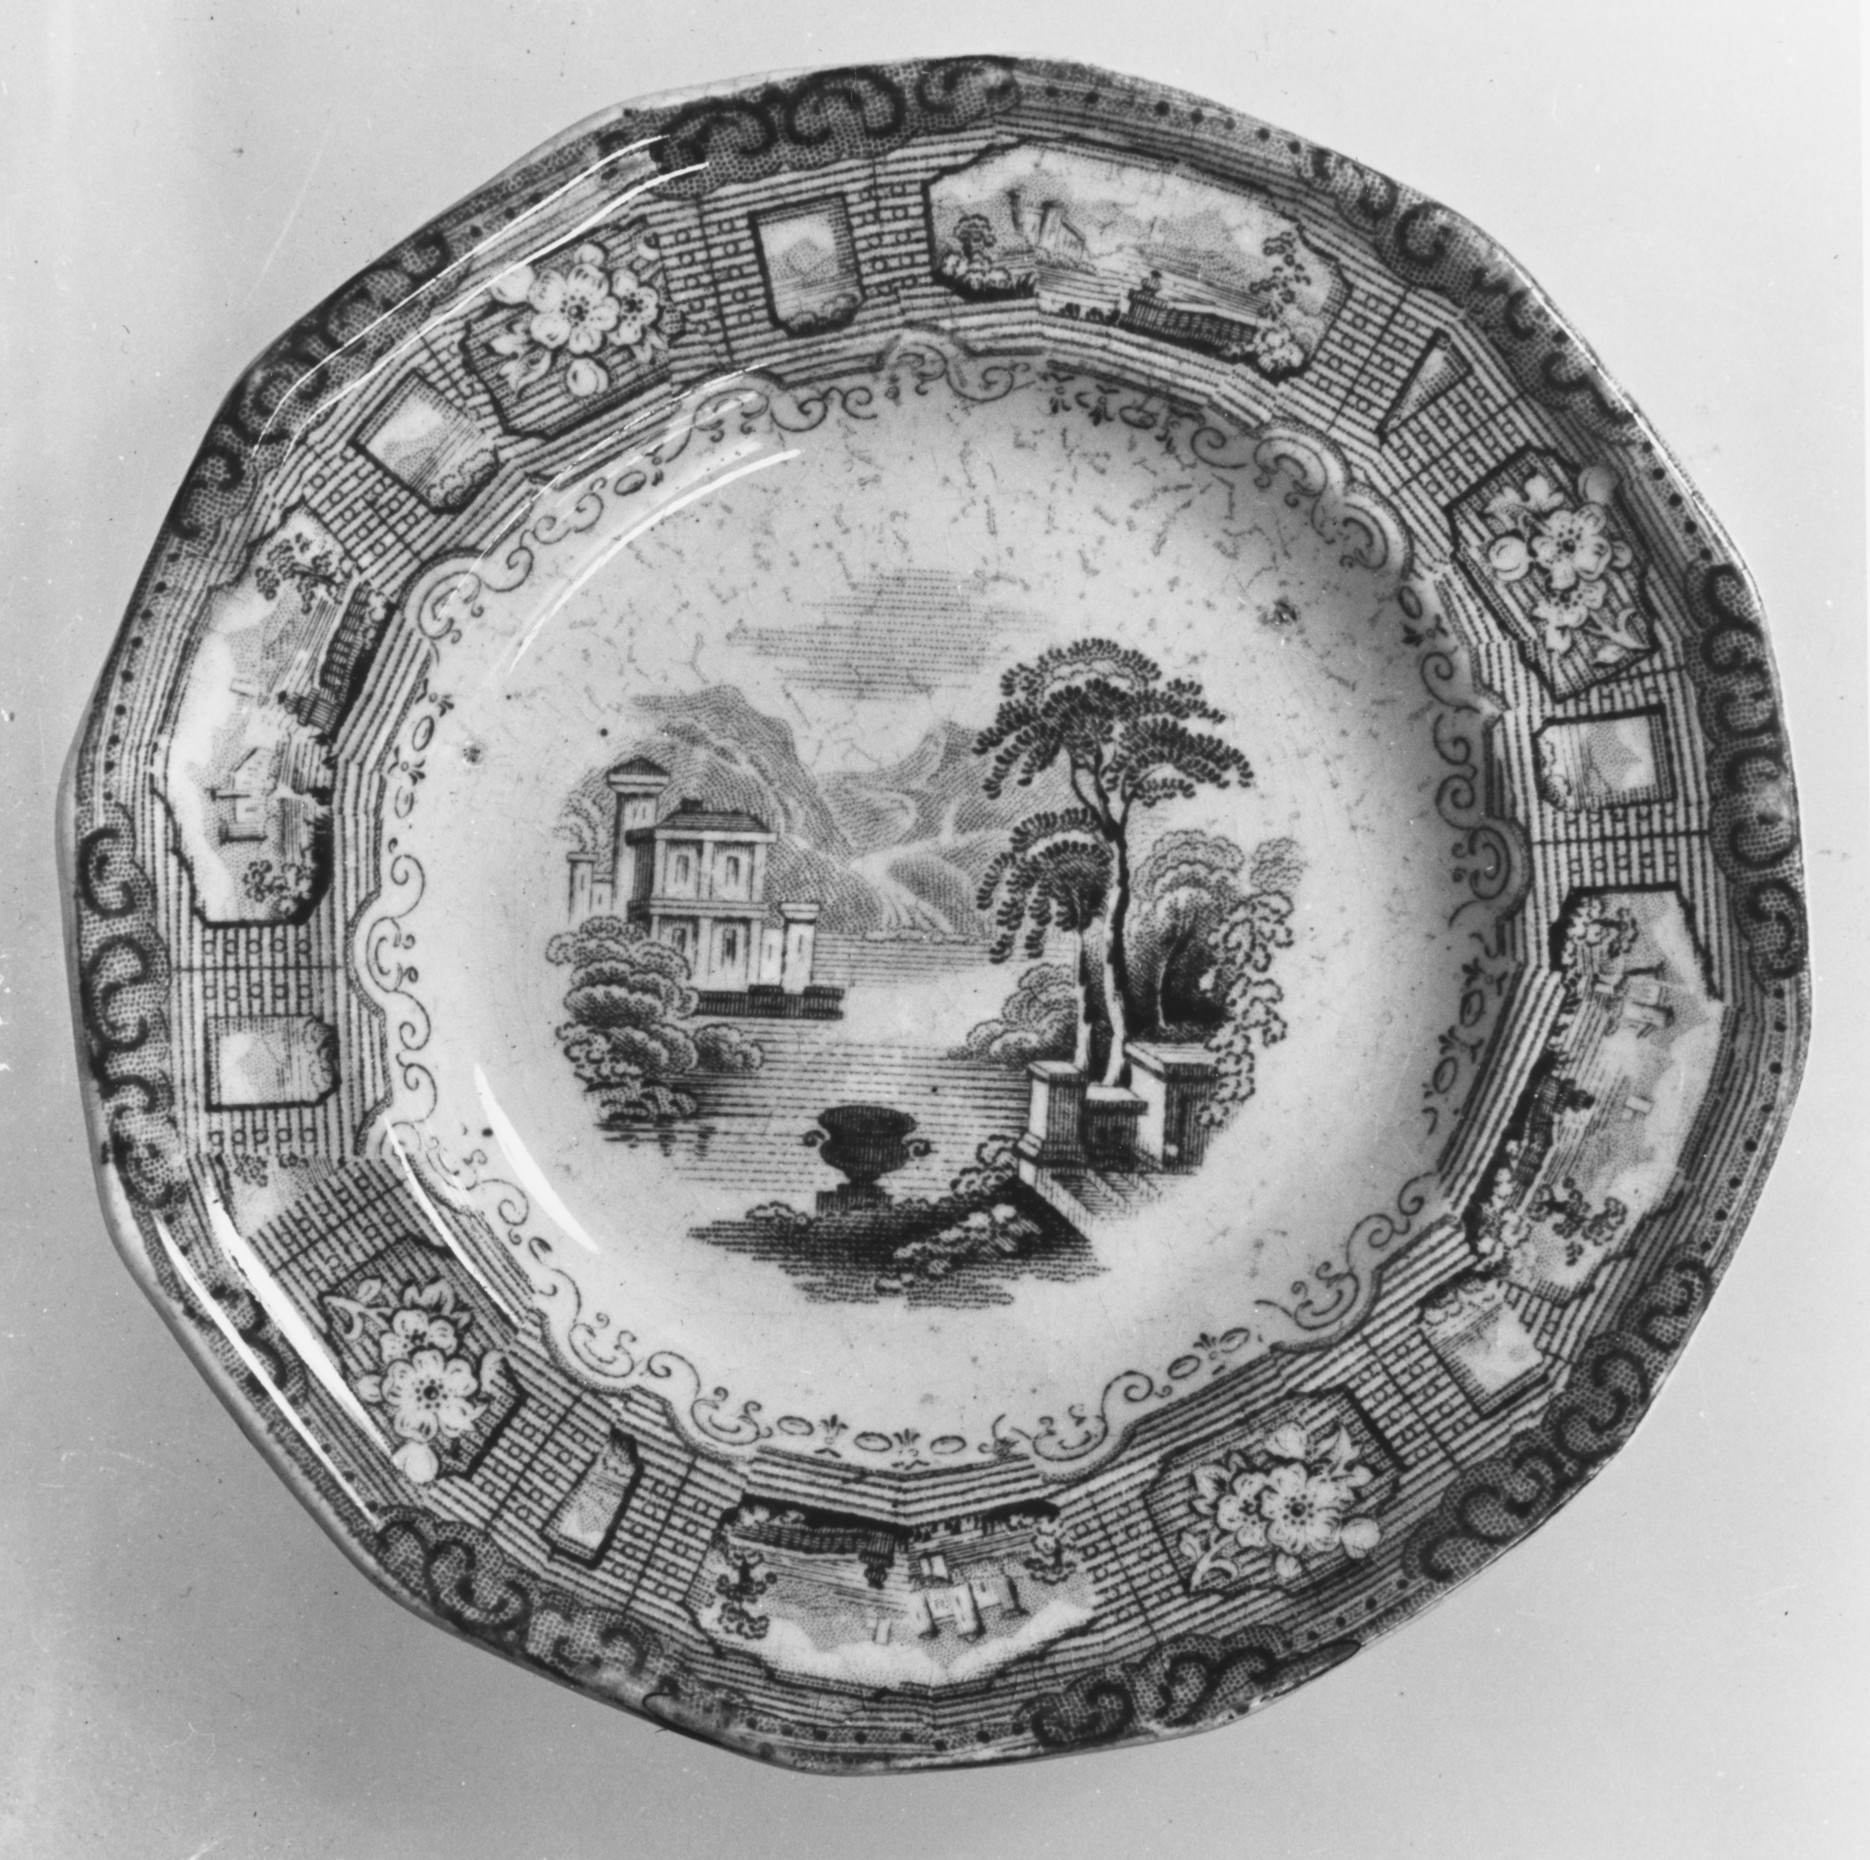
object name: plate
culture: british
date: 1815-1835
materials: earthenware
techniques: transfer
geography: england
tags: landscapes